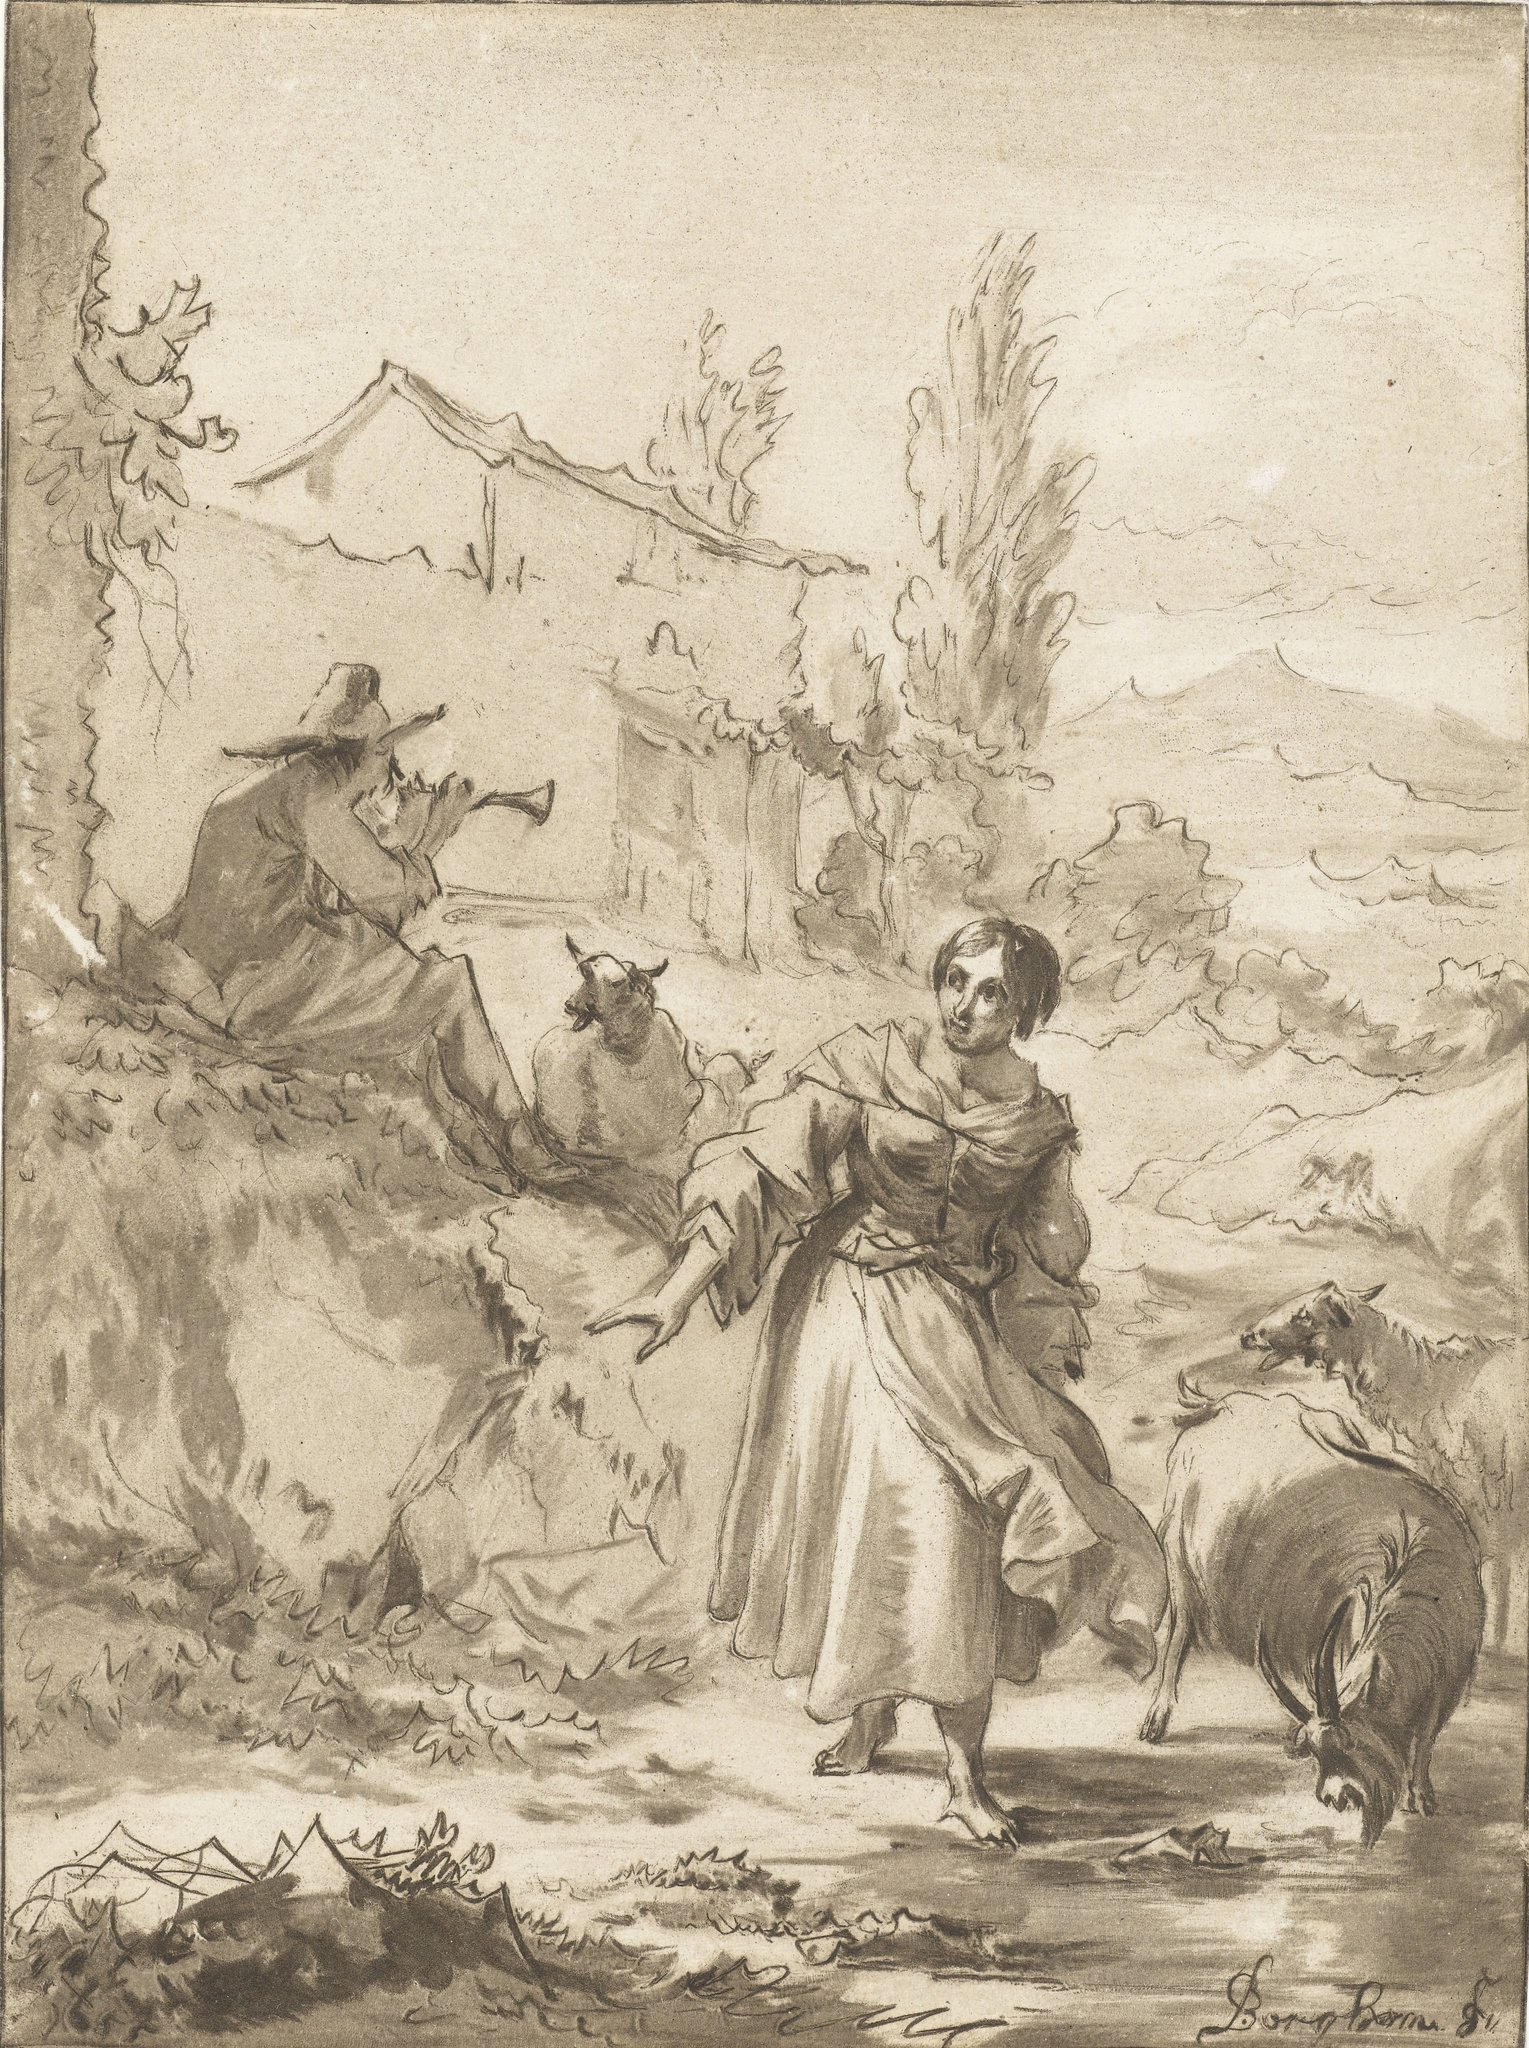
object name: print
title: Herder met schalmei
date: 1724-1798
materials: paper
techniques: print drawing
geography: amsterdam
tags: one person playing wind instrument - cc - out of doors, herding, herdsman, herdswoman, shepherd, shepherdess, cowherd, etc., clarinet, bassoon, oboe, shawm, spinning (manufacture of yarn), herd, flock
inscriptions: collector's mark: Lugt 12, collector's mark: Lugt 2725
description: Een herder zit op een rots en speelt schalmei. Naast hem staat een herderin. Geiten liggen rondom het paar.